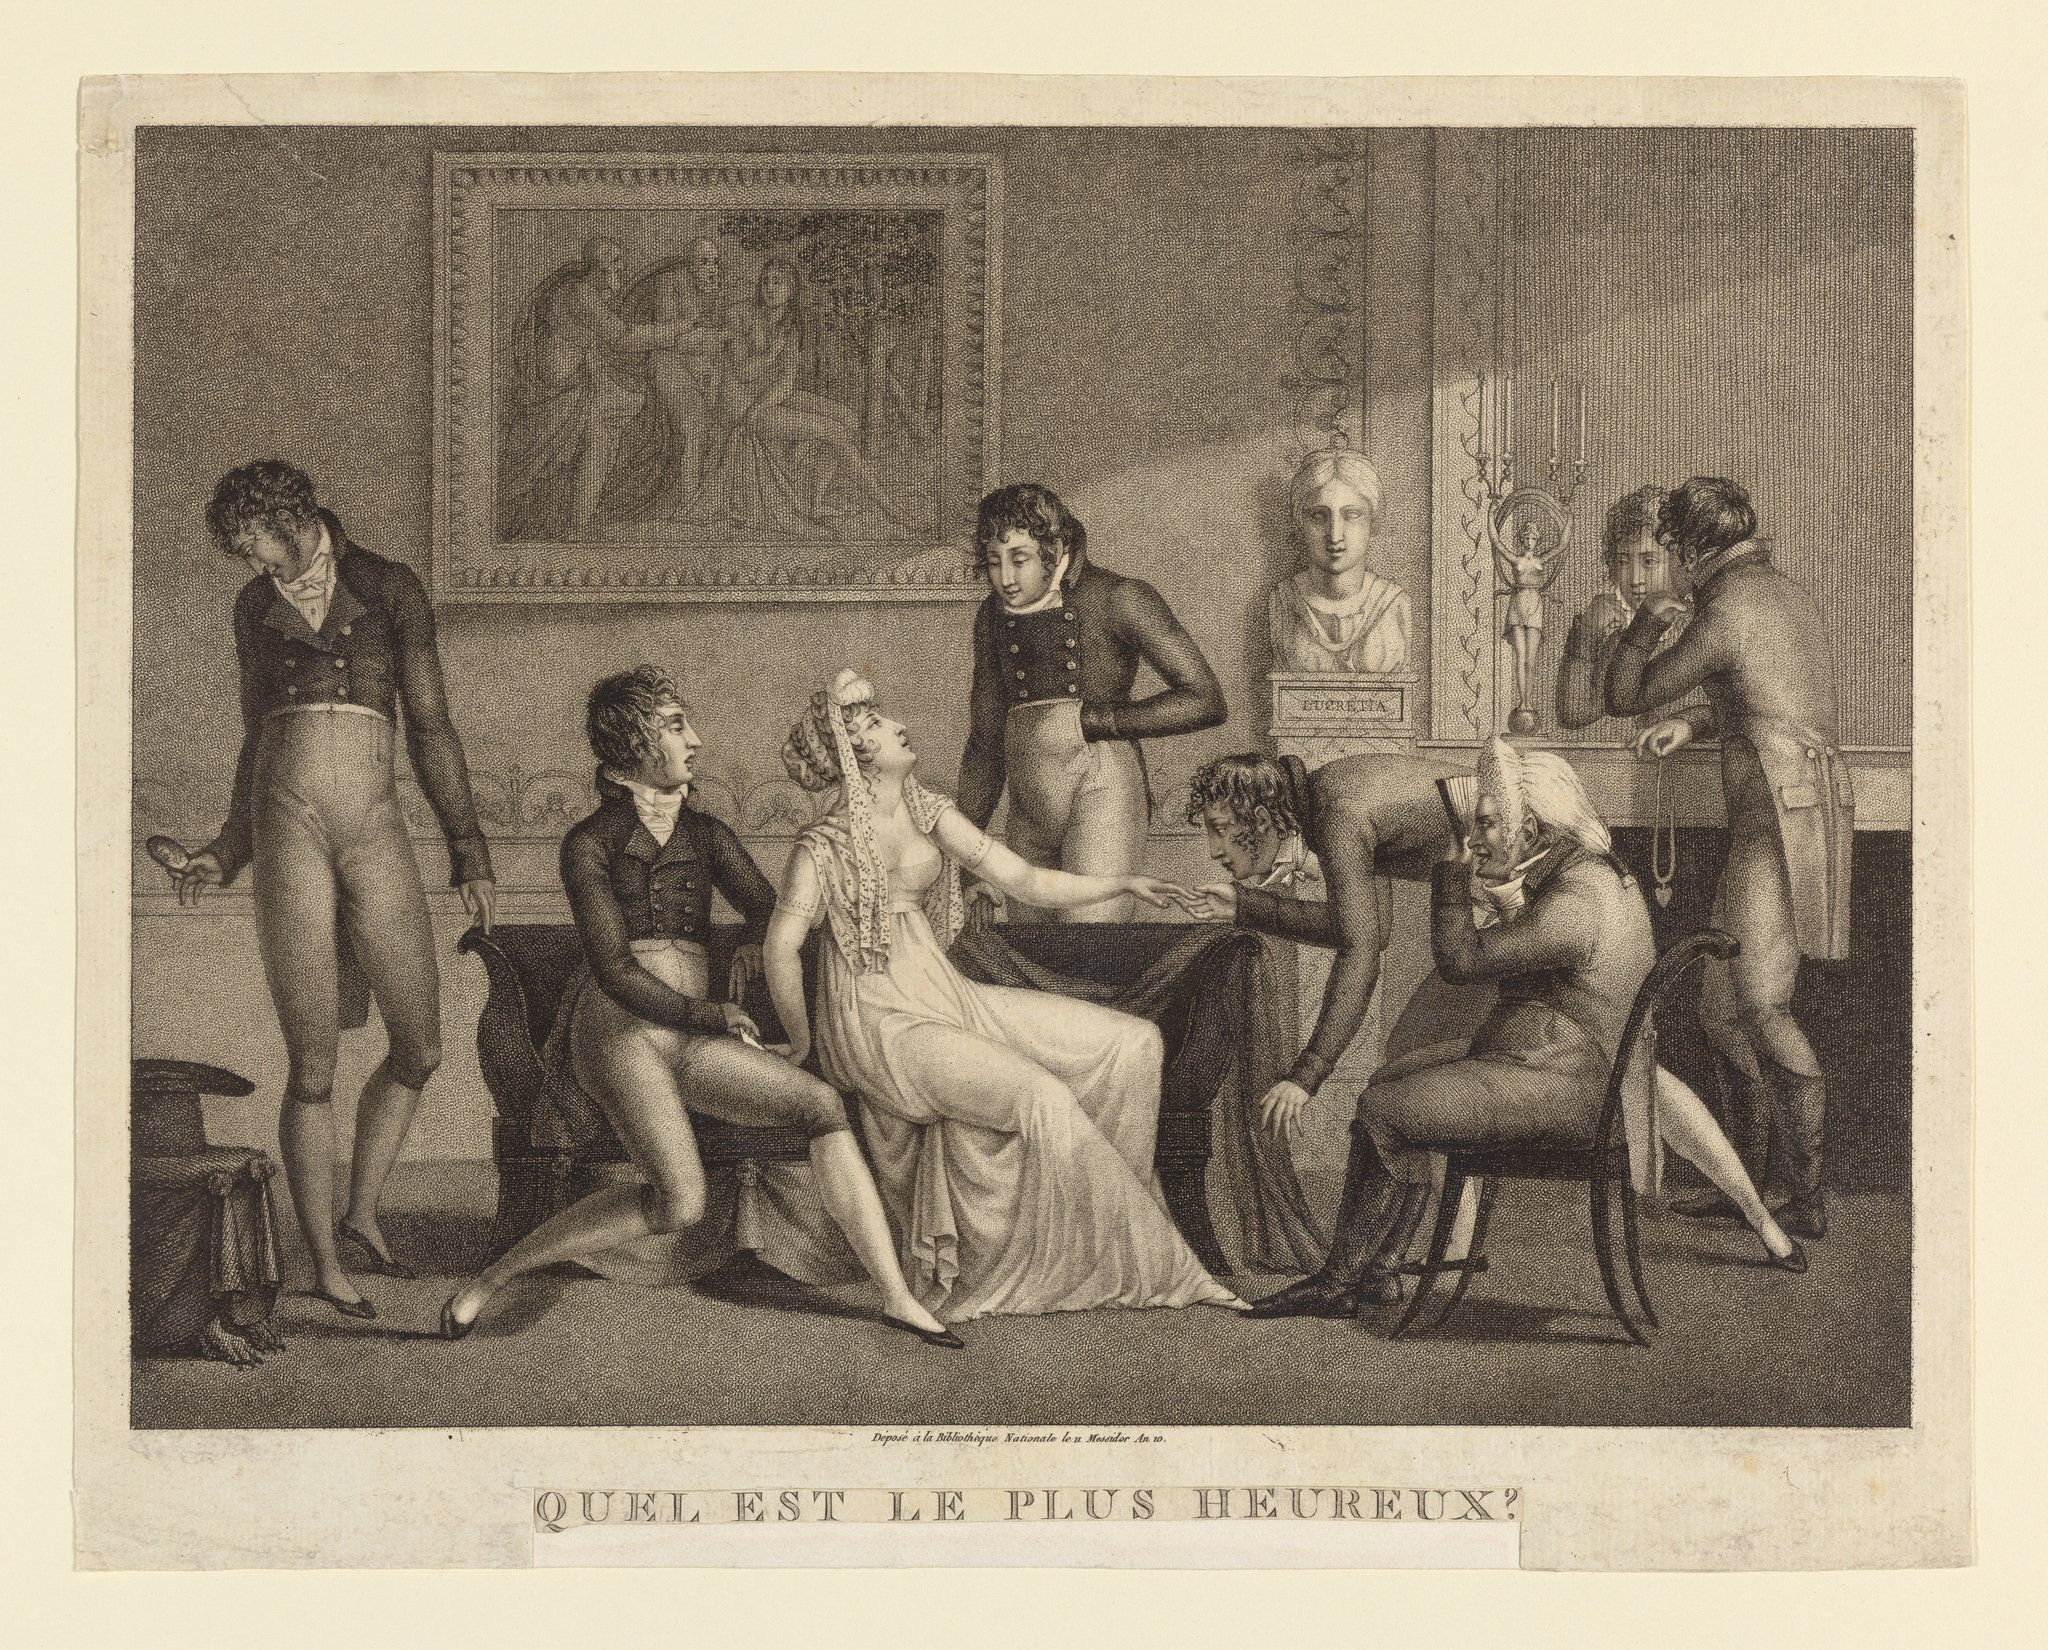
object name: print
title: Quel est le plus heureux?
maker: marguerite eléonore lingée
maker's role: artist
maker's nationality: french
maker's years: 1773-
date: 1802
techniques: engraving, etching